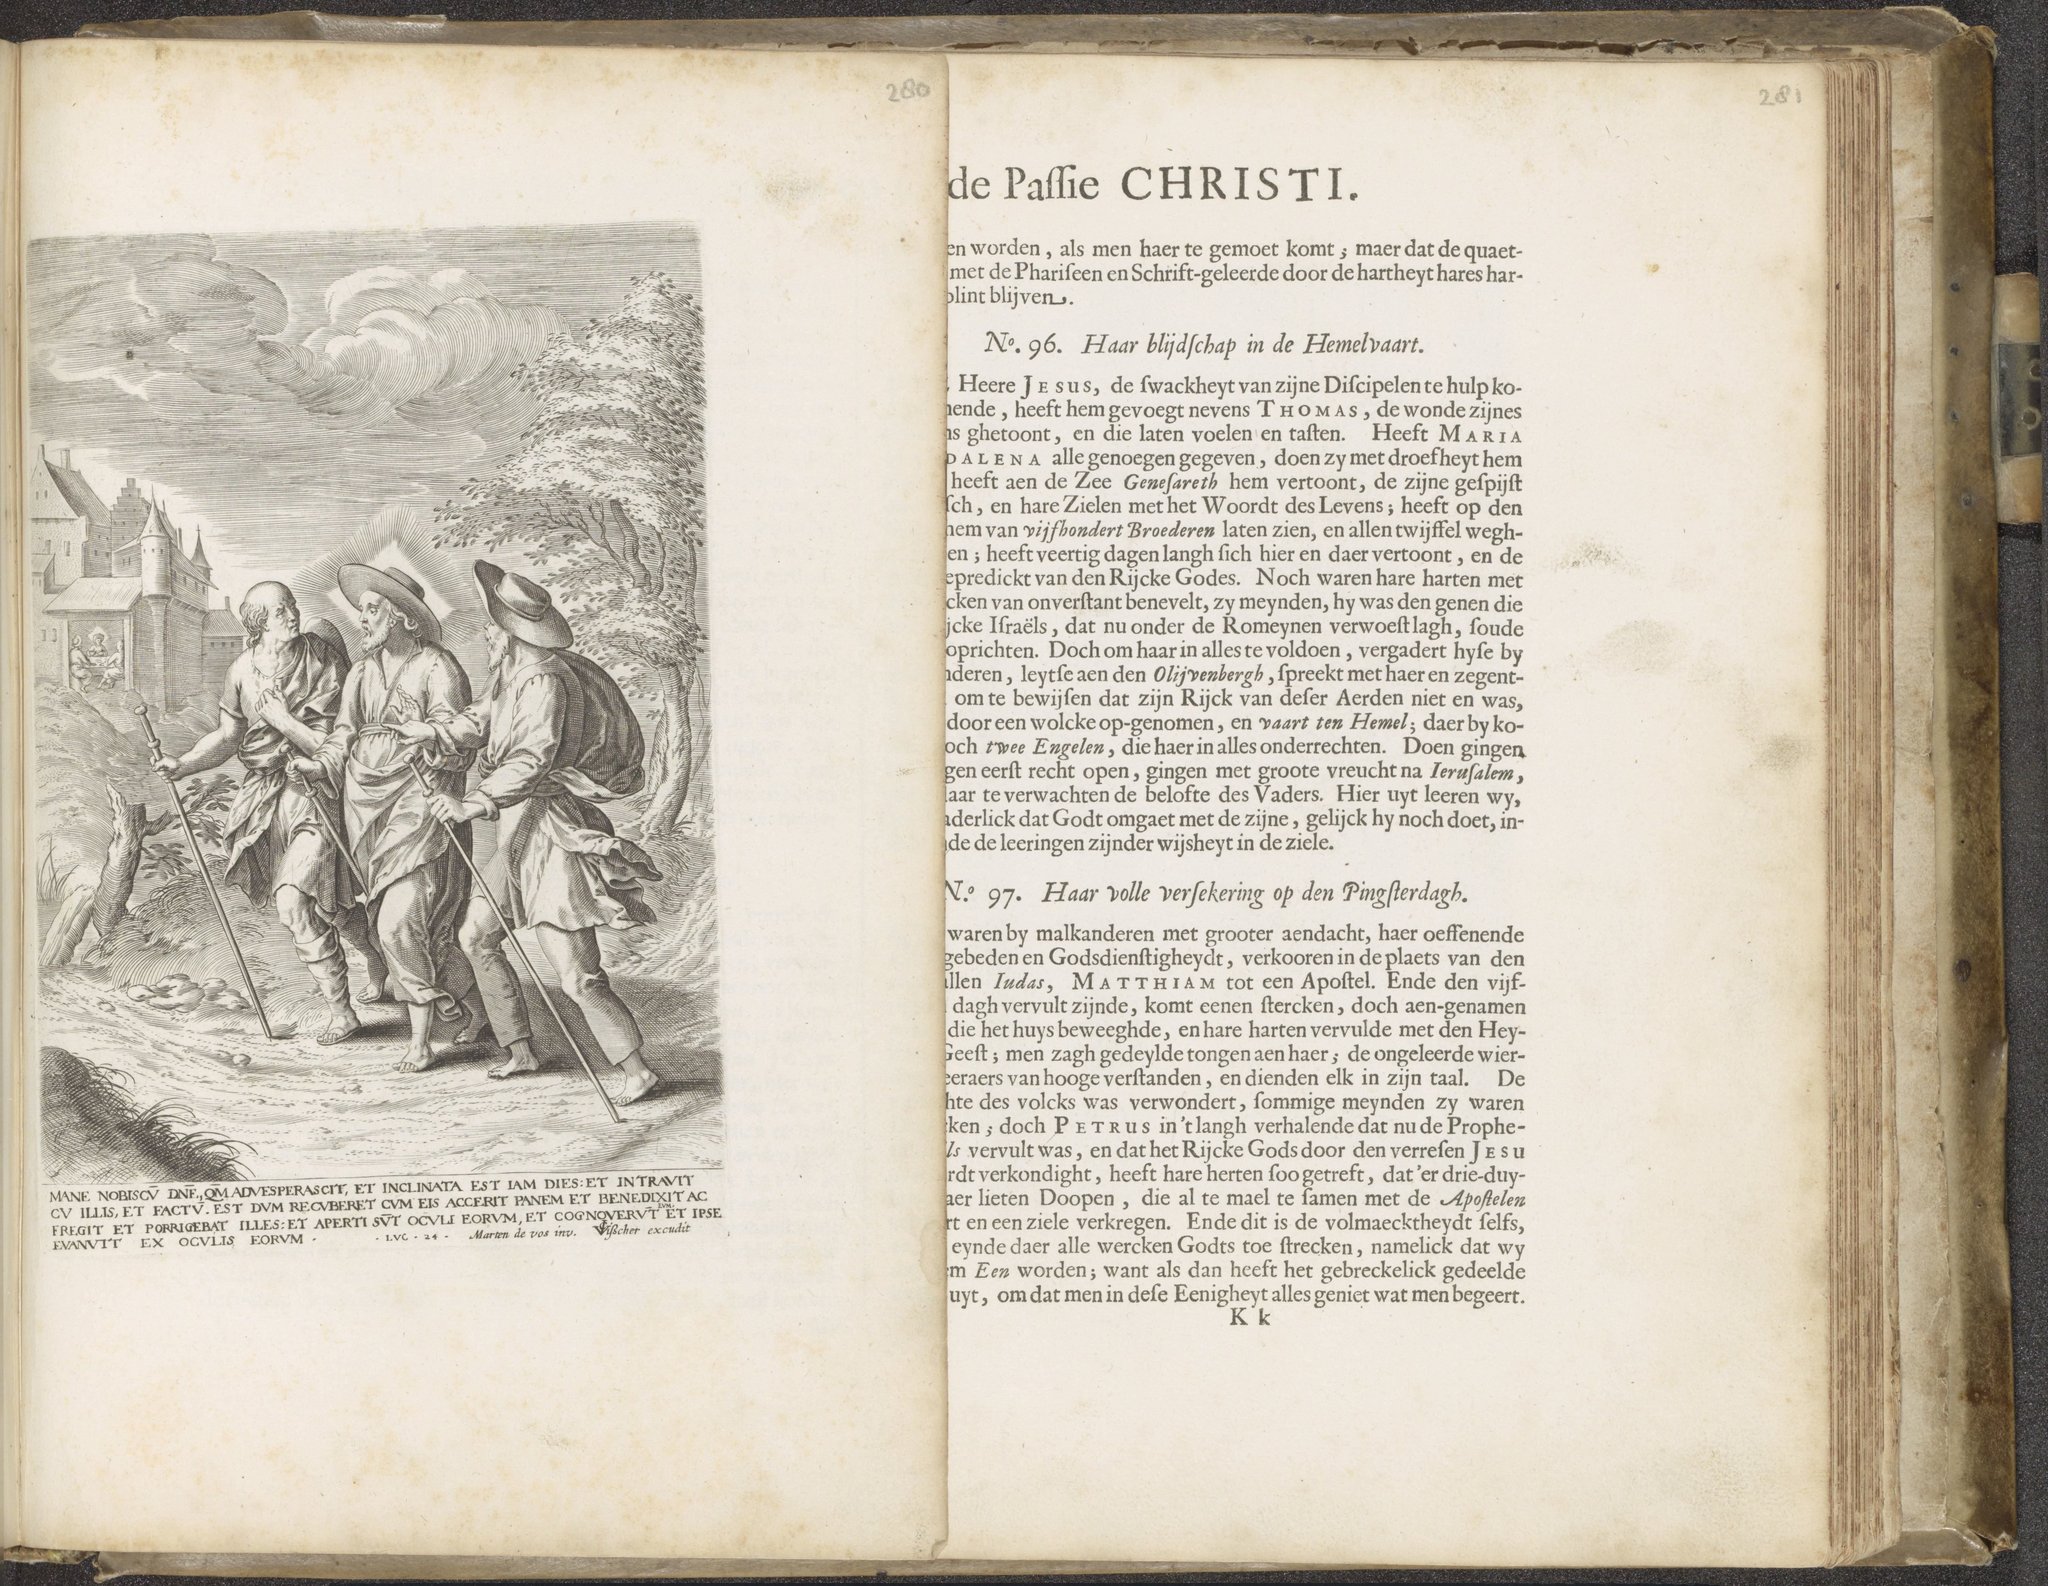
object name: print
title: Den Grooten Emblemata Sacra, bestaande in meer dan vier hondert bybelsche figuren, zoo des Ouden als des Nieuwen Testaments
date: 1601-1652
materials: paper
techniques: engraving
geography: amsterdam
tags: the supper at emmaus: christ is recognized while blessing or breaking the bread, cleopas and peter meet christ (sometimes they are dressed as pilgrims)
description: Christus ontmoet twee leerlingen en loopt met hen mee naar het dorp Emmaüs. Zij herkennen Christus niet. Op de achtergrond links de maaltijd in Emmaüs. In de ondermarge een tekst in het Latijn, afkomstig uit Lucas 24: 29-31. Het blad maakt deel uit van een album.